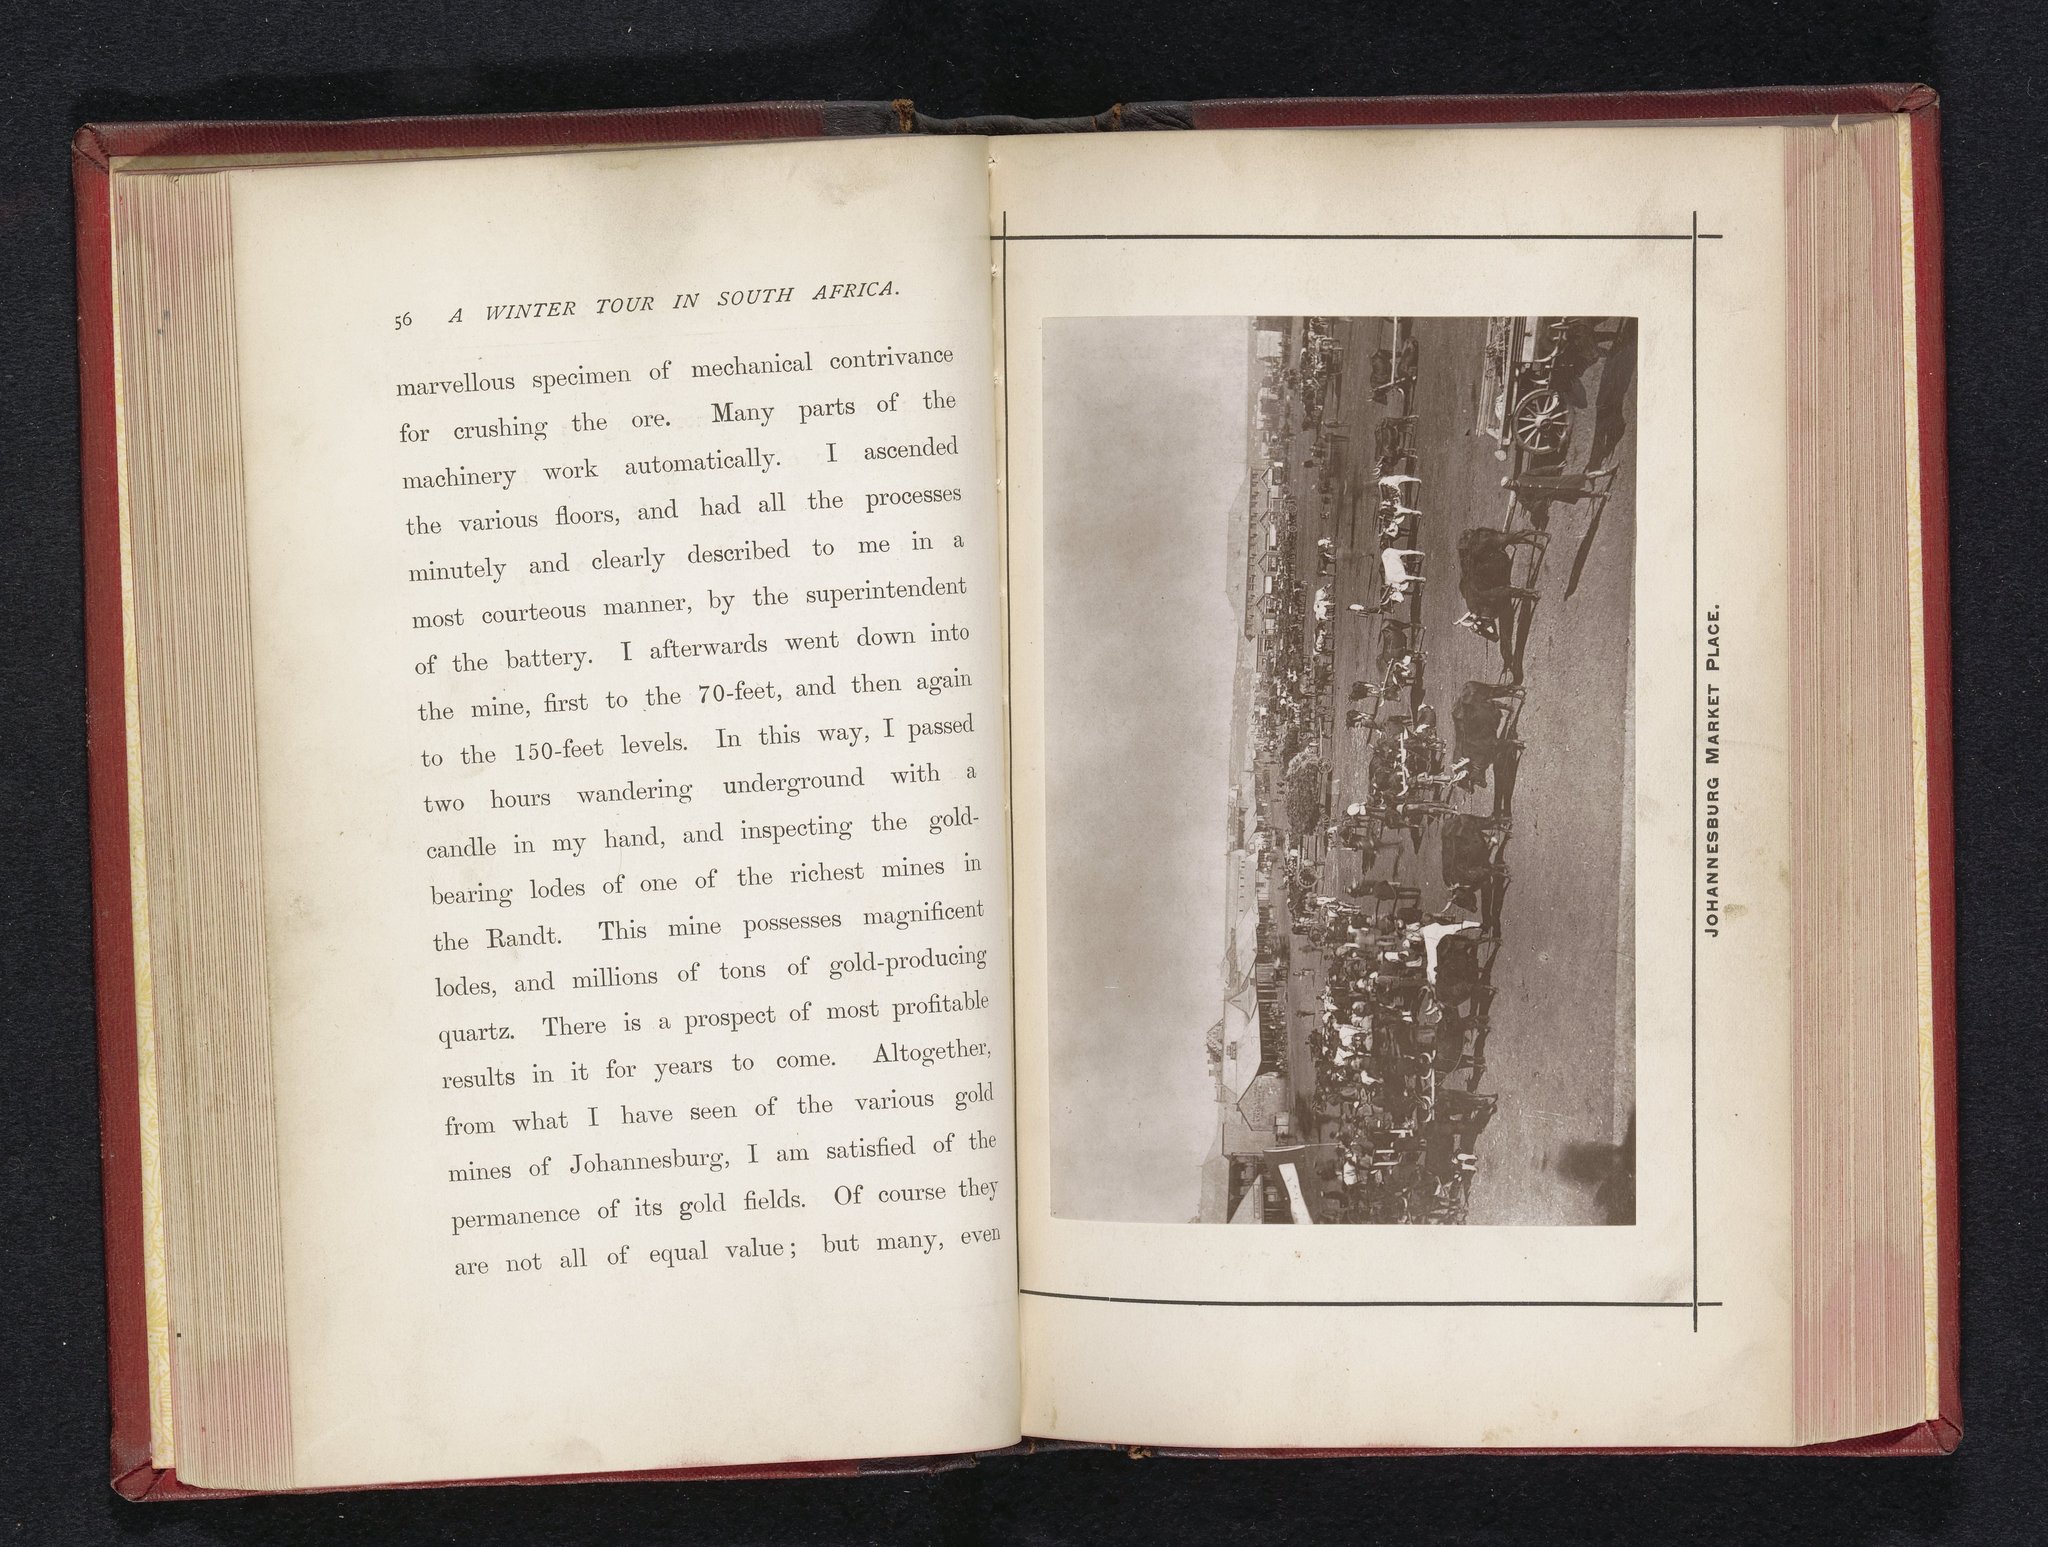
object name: photomechanical print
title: Johannesburg market place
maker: Anonymous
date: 1888-1890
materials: paper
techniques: woodburytype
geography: johannesburg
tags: cow, market, johannesburg